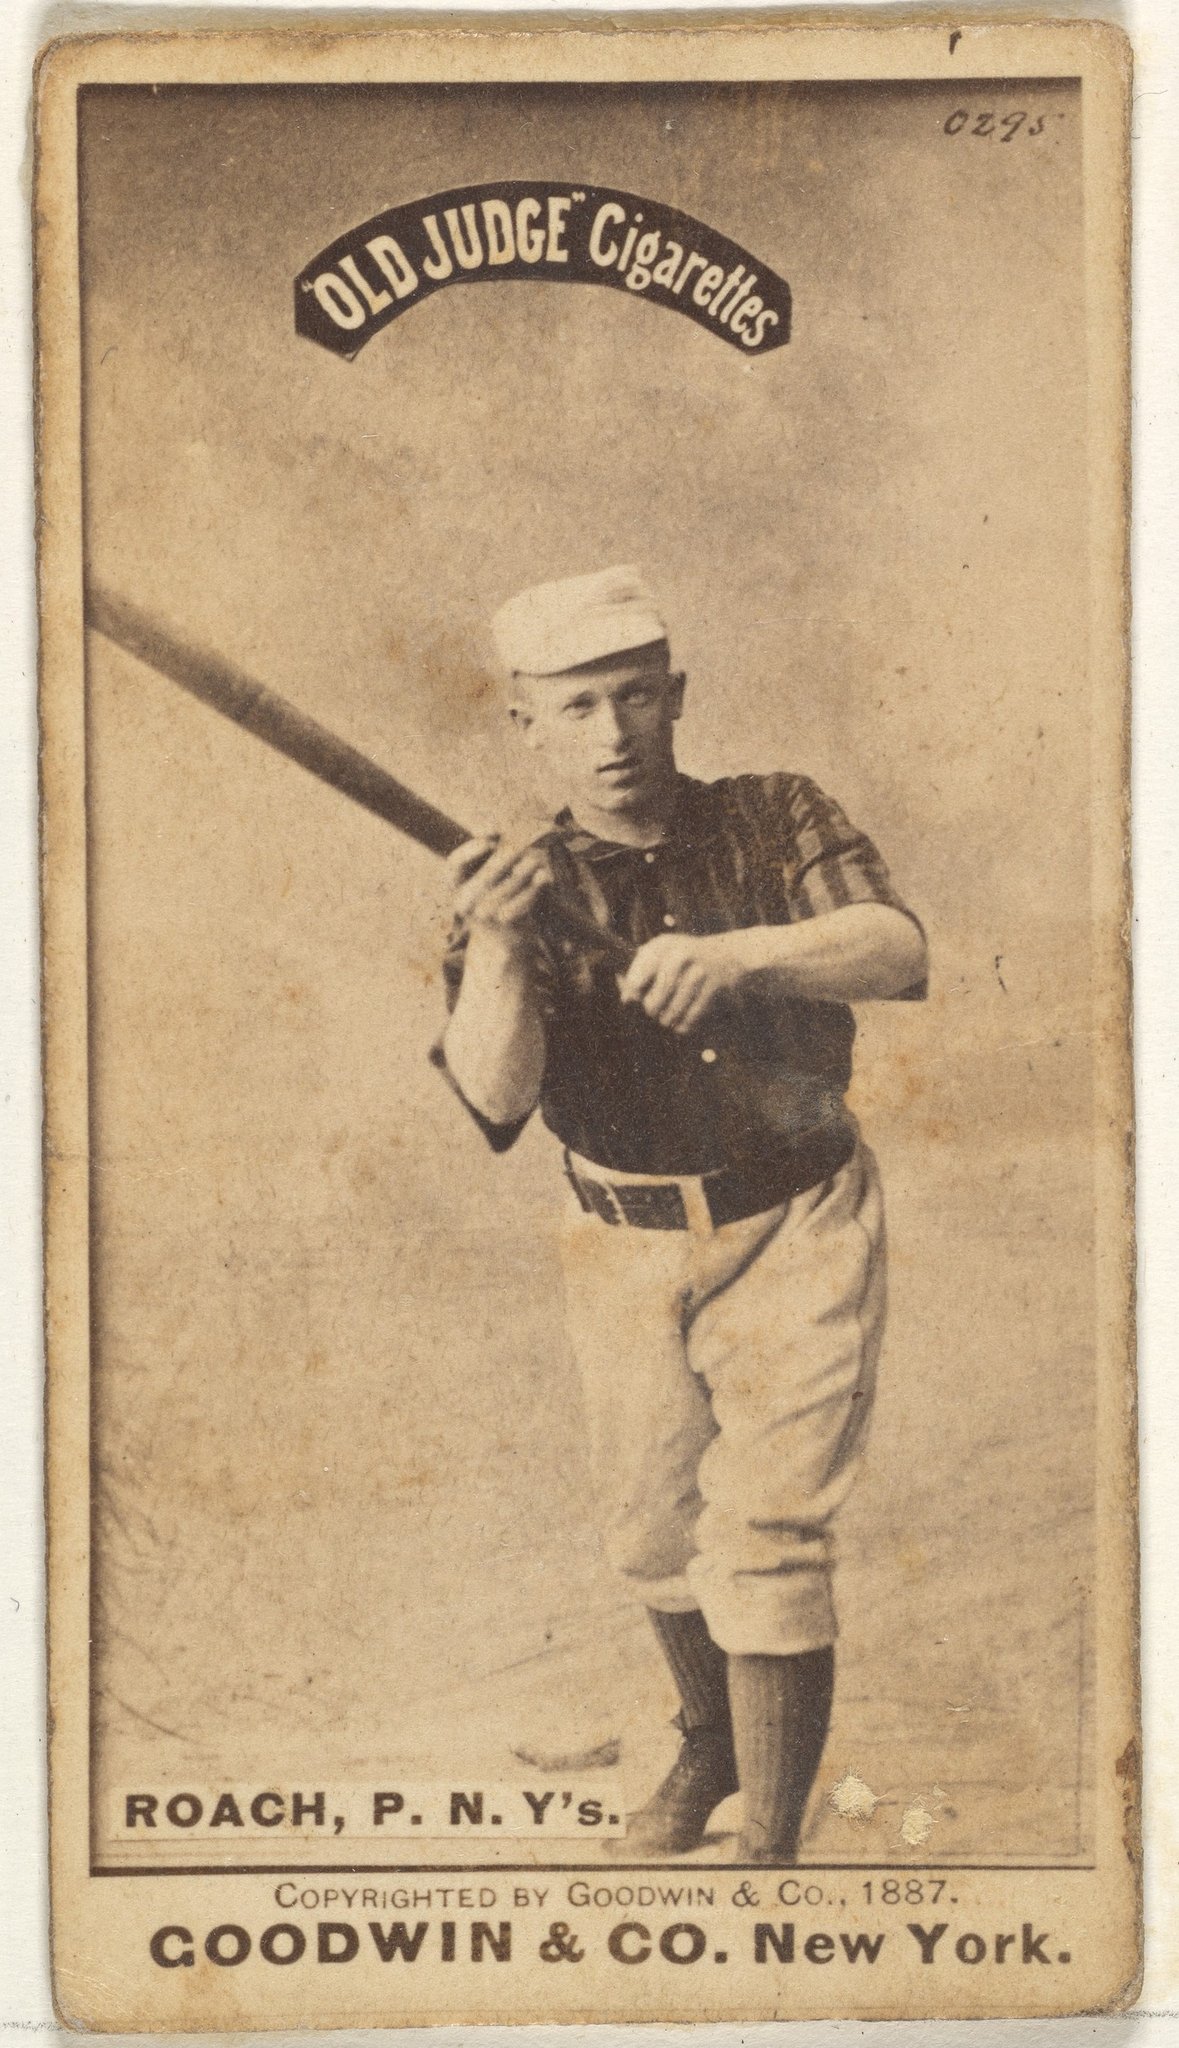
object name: baseball card, photograph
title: John F. Roach, Pitcher, New York, from the Old Judge series (N172) for Old Judge Cigarettes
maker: goodwin & company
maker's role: publisher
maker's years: 1850-1950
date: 1887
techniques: albumen silver print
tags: men,portraits,baseball,athletes